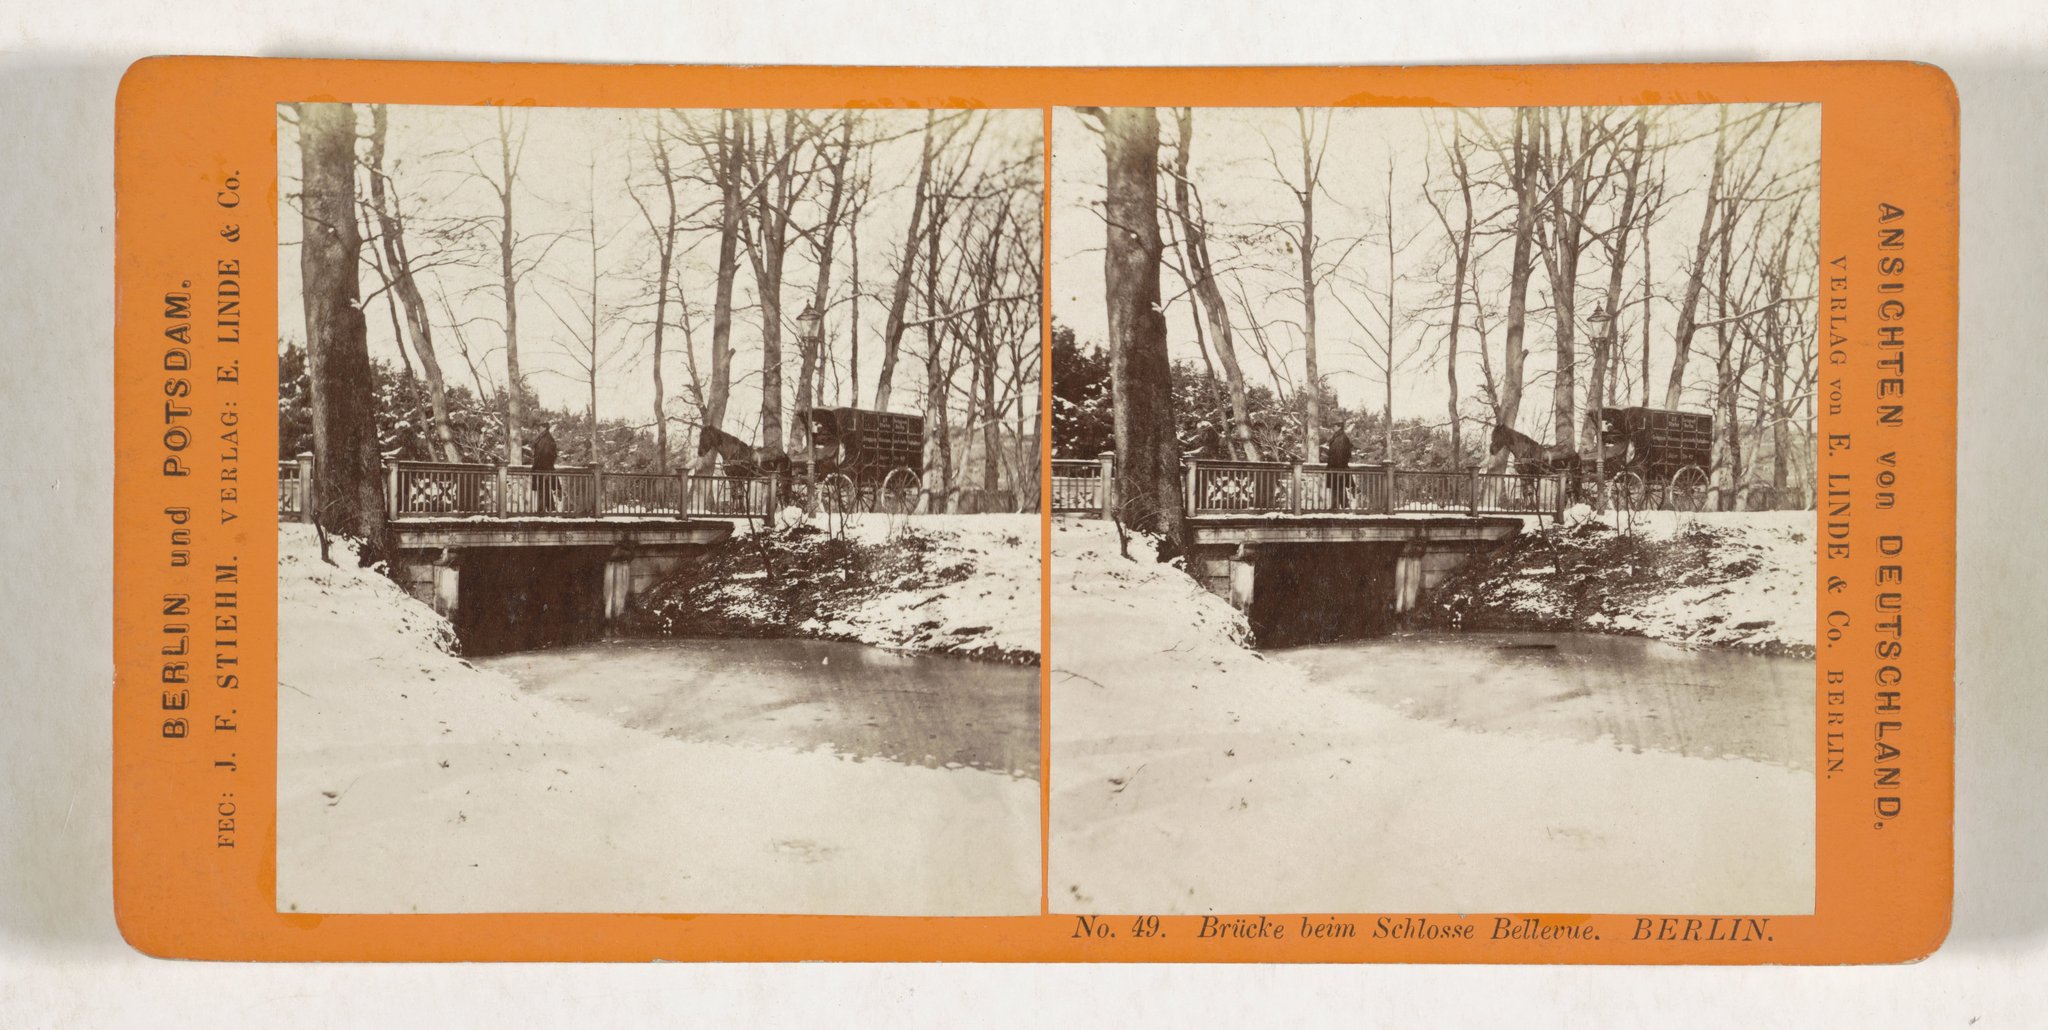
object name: stereograph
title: Ansichten von Deutschland / Berlin und Potsdam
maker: johann friedrich stiehm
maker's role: fotograaf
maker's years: 1826-1902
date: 1868-1870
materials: cardboard, paper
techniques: albumen print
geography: großer tiergarten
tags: bridge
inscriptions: number: ‘No. 49.’